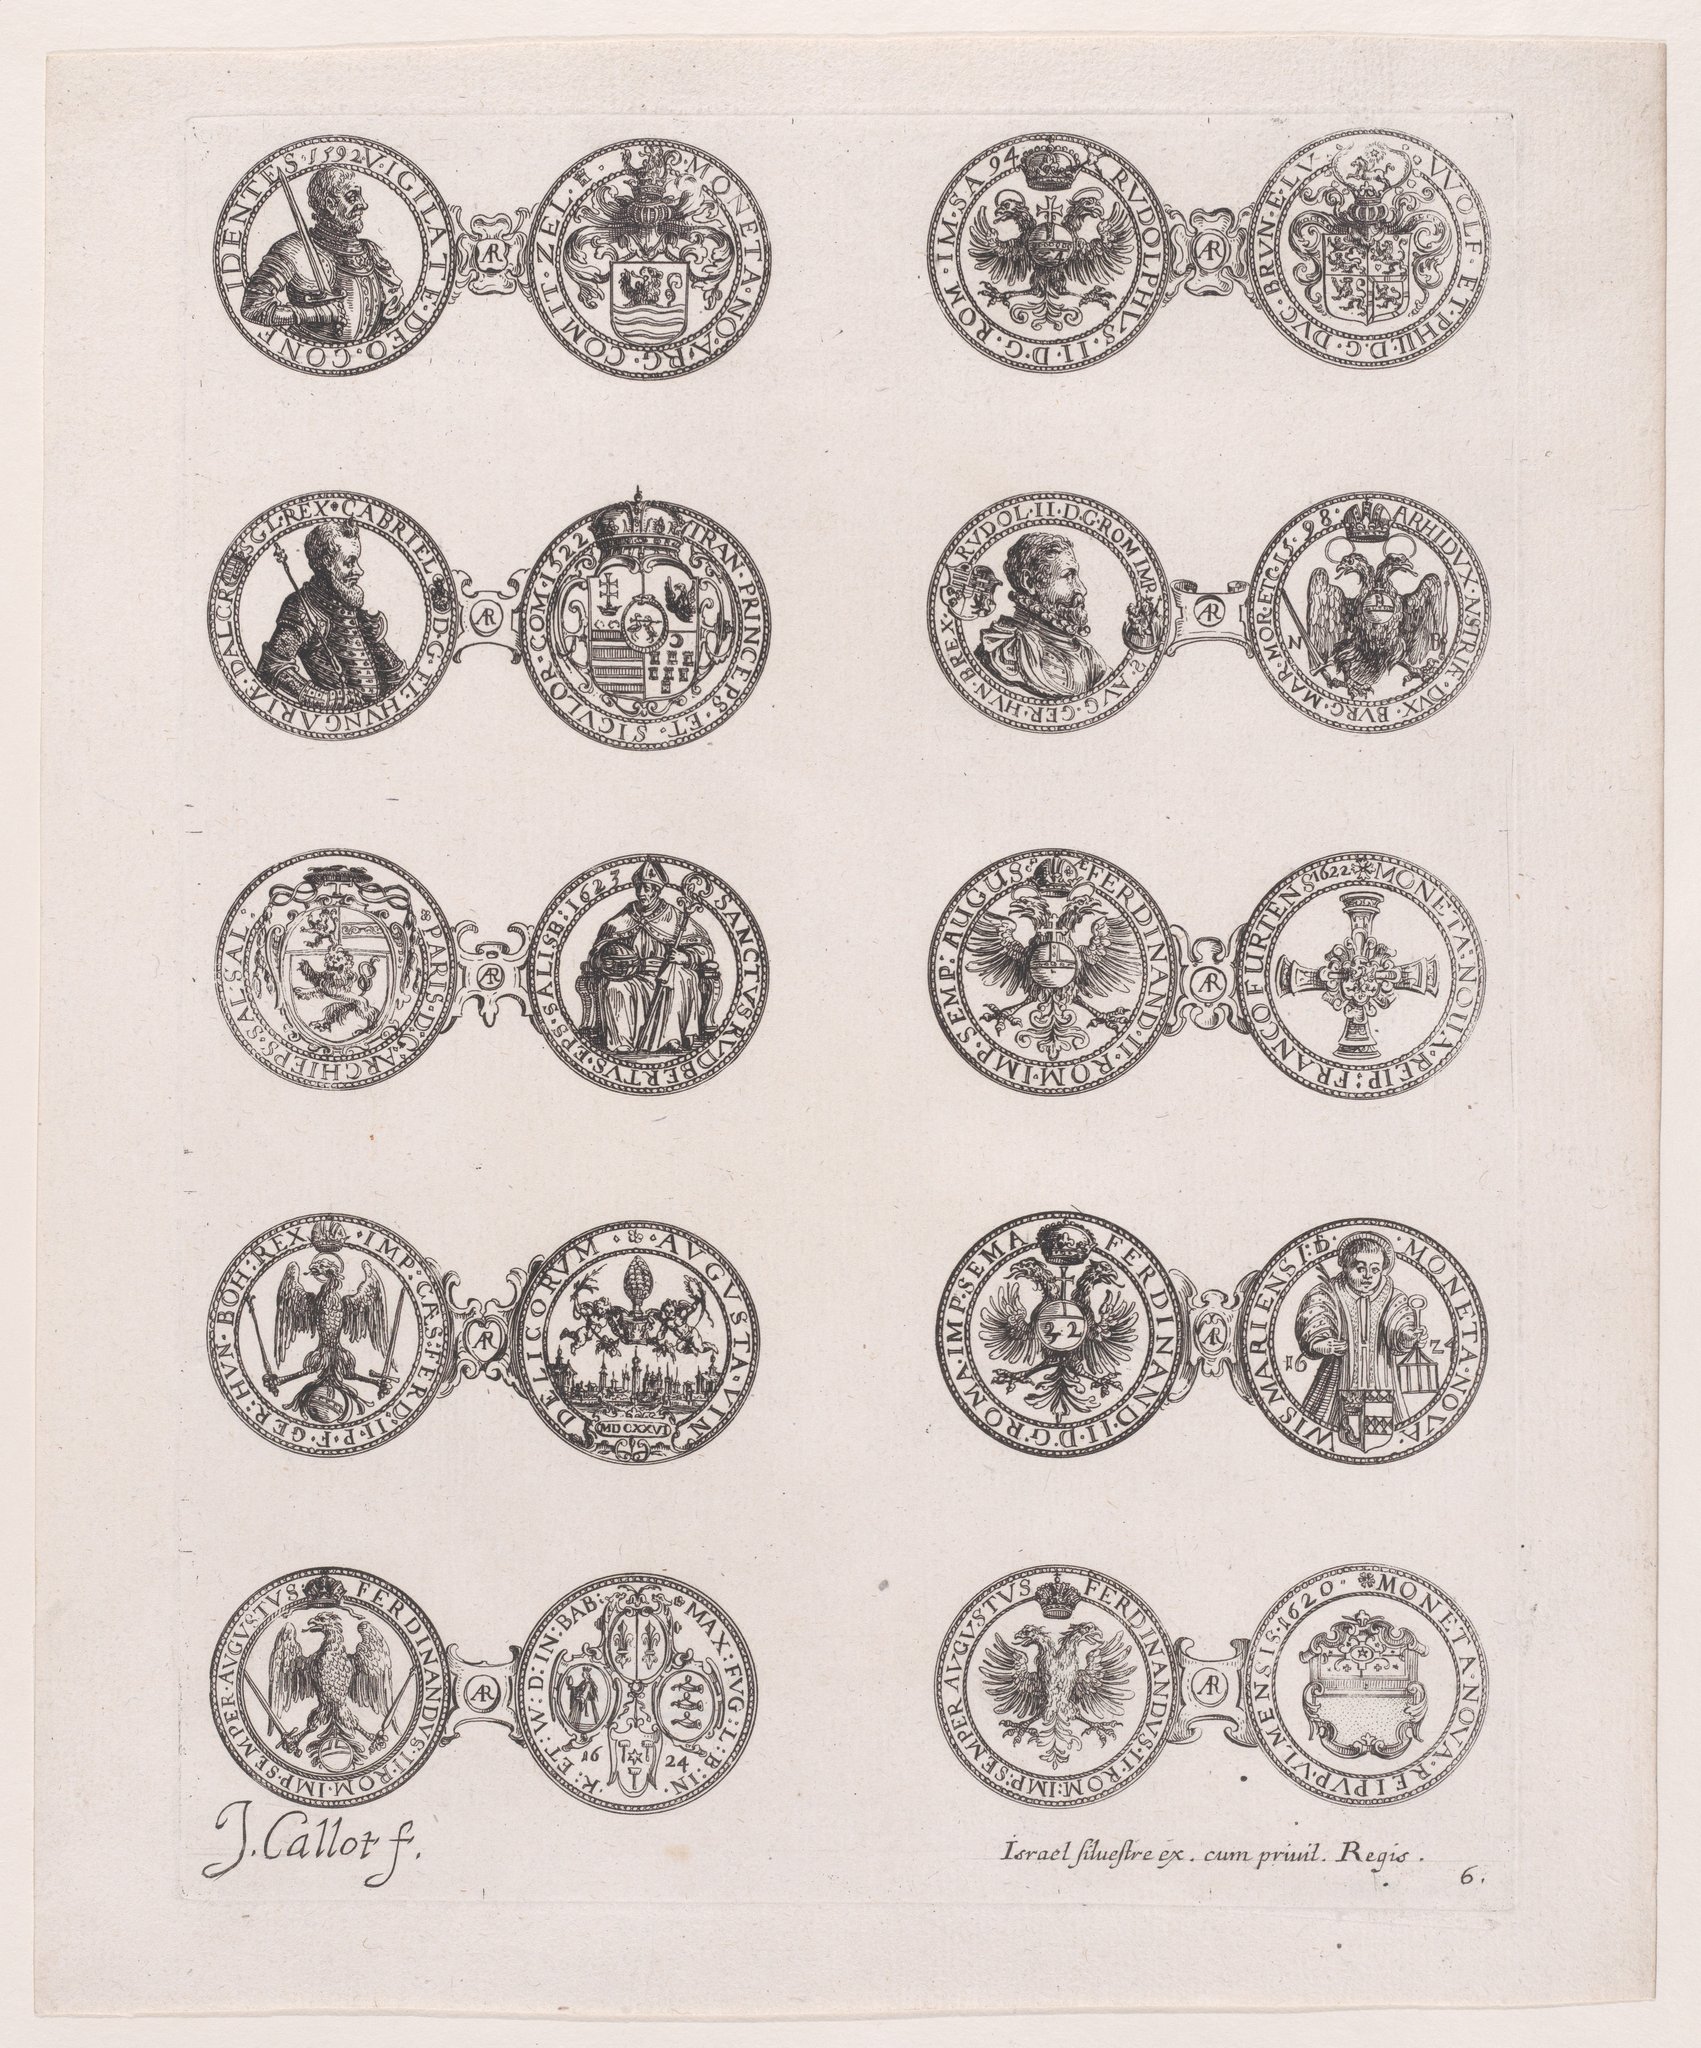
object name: print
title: Plate 6, Featuring 10 Coins Issued by European Princes in the 16th and 17th centuries, from "Les Monnaies" (The Currencies)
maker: jacques callot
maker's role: artist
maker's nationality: french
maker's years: 1592-1635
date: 1630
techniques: etching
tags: coins